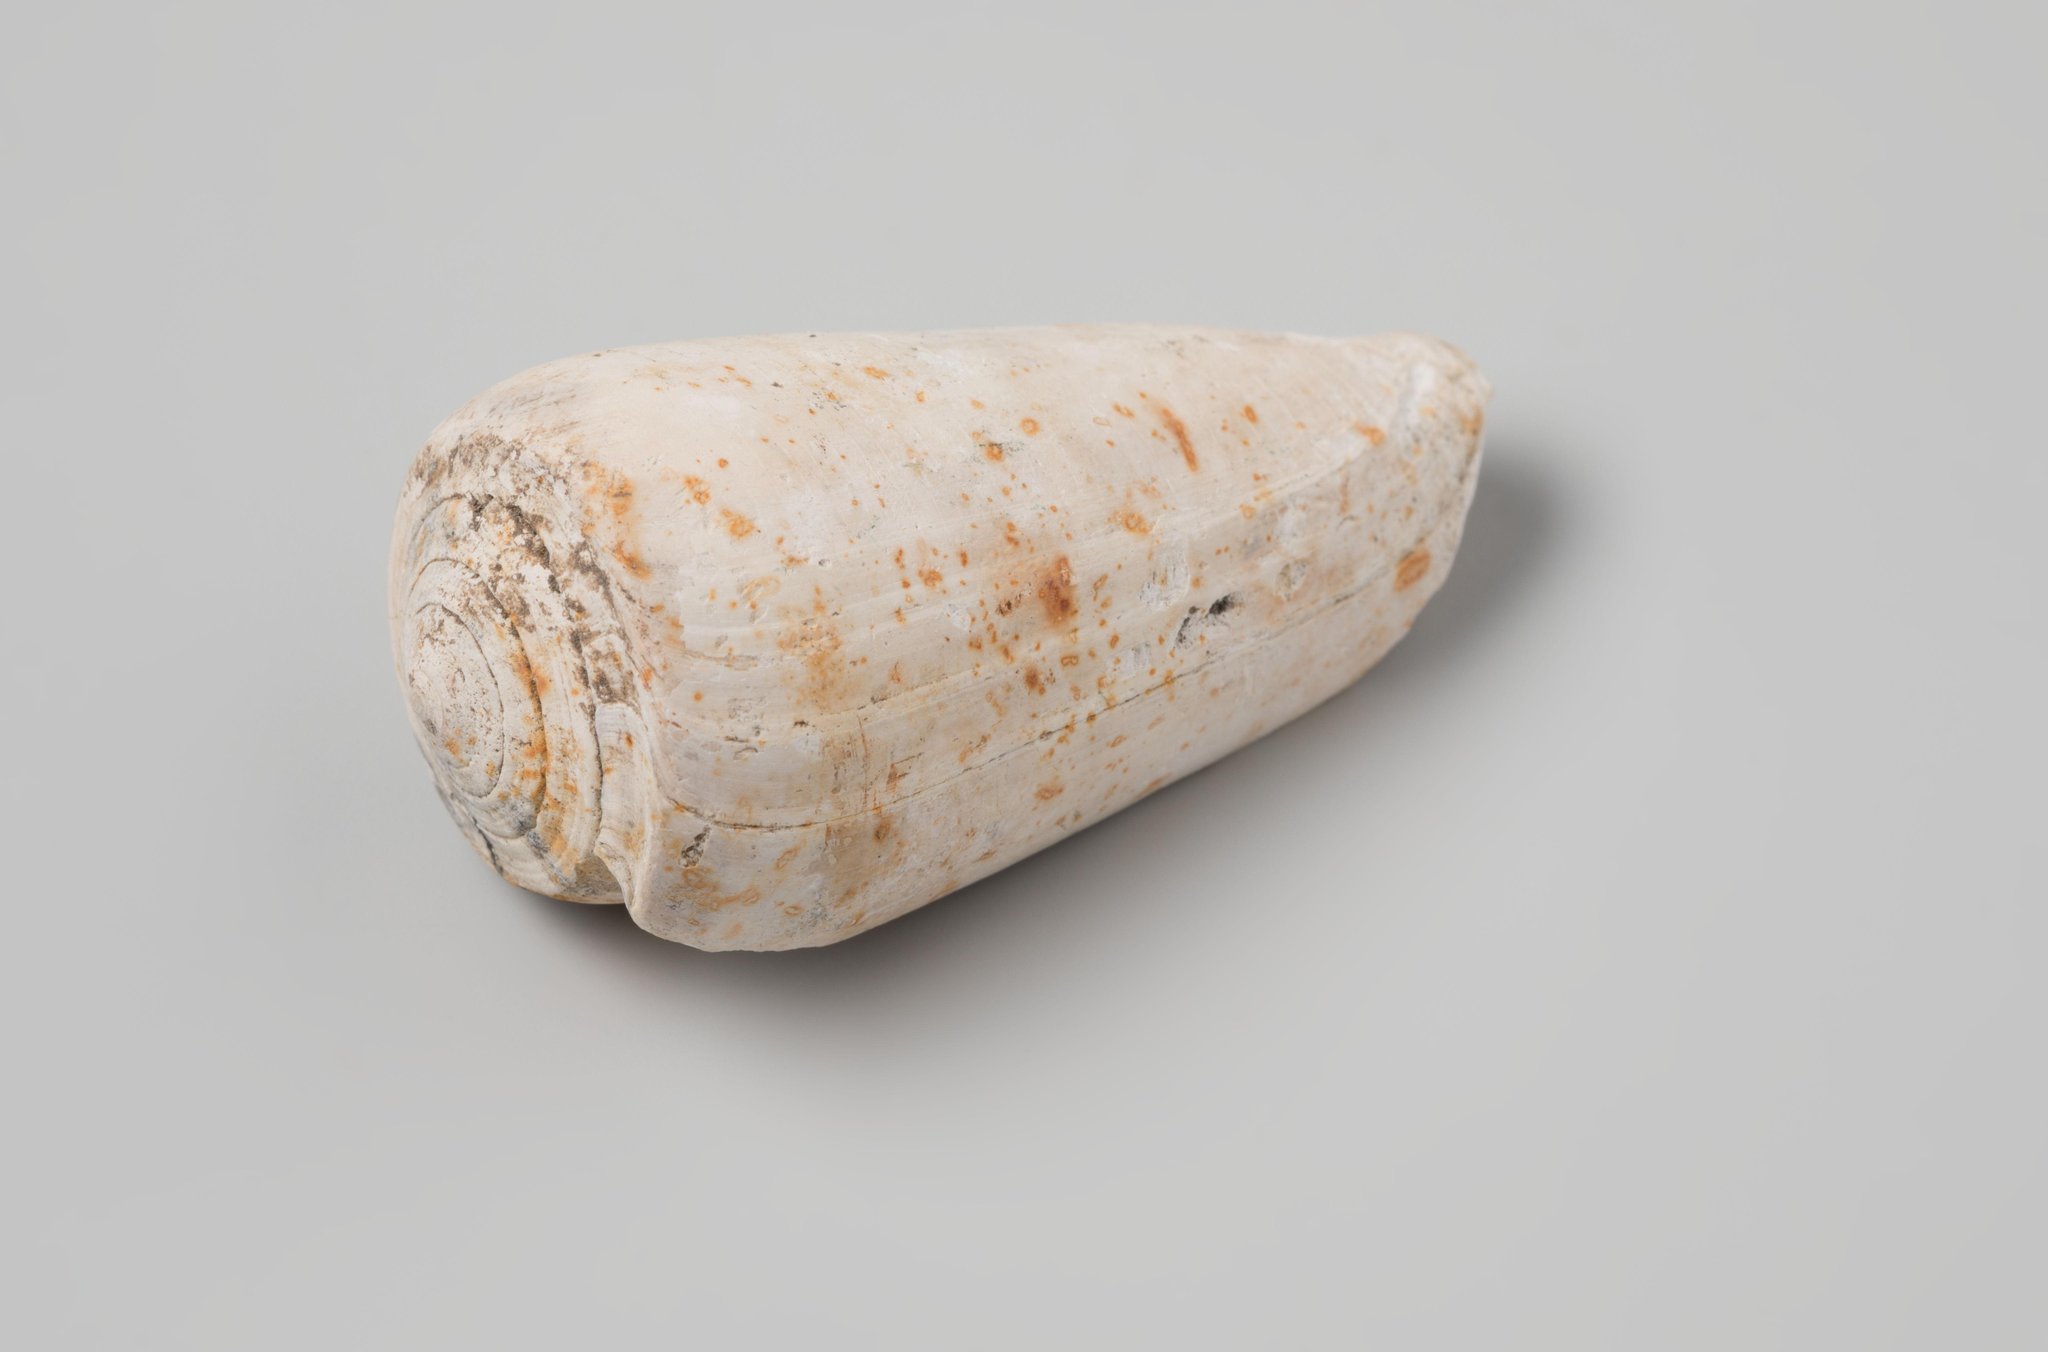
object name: conus magus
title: Conus magnus shell from the wreck of the Dutch East India ship Witte Leeuw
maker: niet van toepassing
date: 1613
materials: shell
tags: verenigde oostindische compagnie, sint-helena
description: Schelp uit V.O.C.-schip de 'Witte Leeuw'.